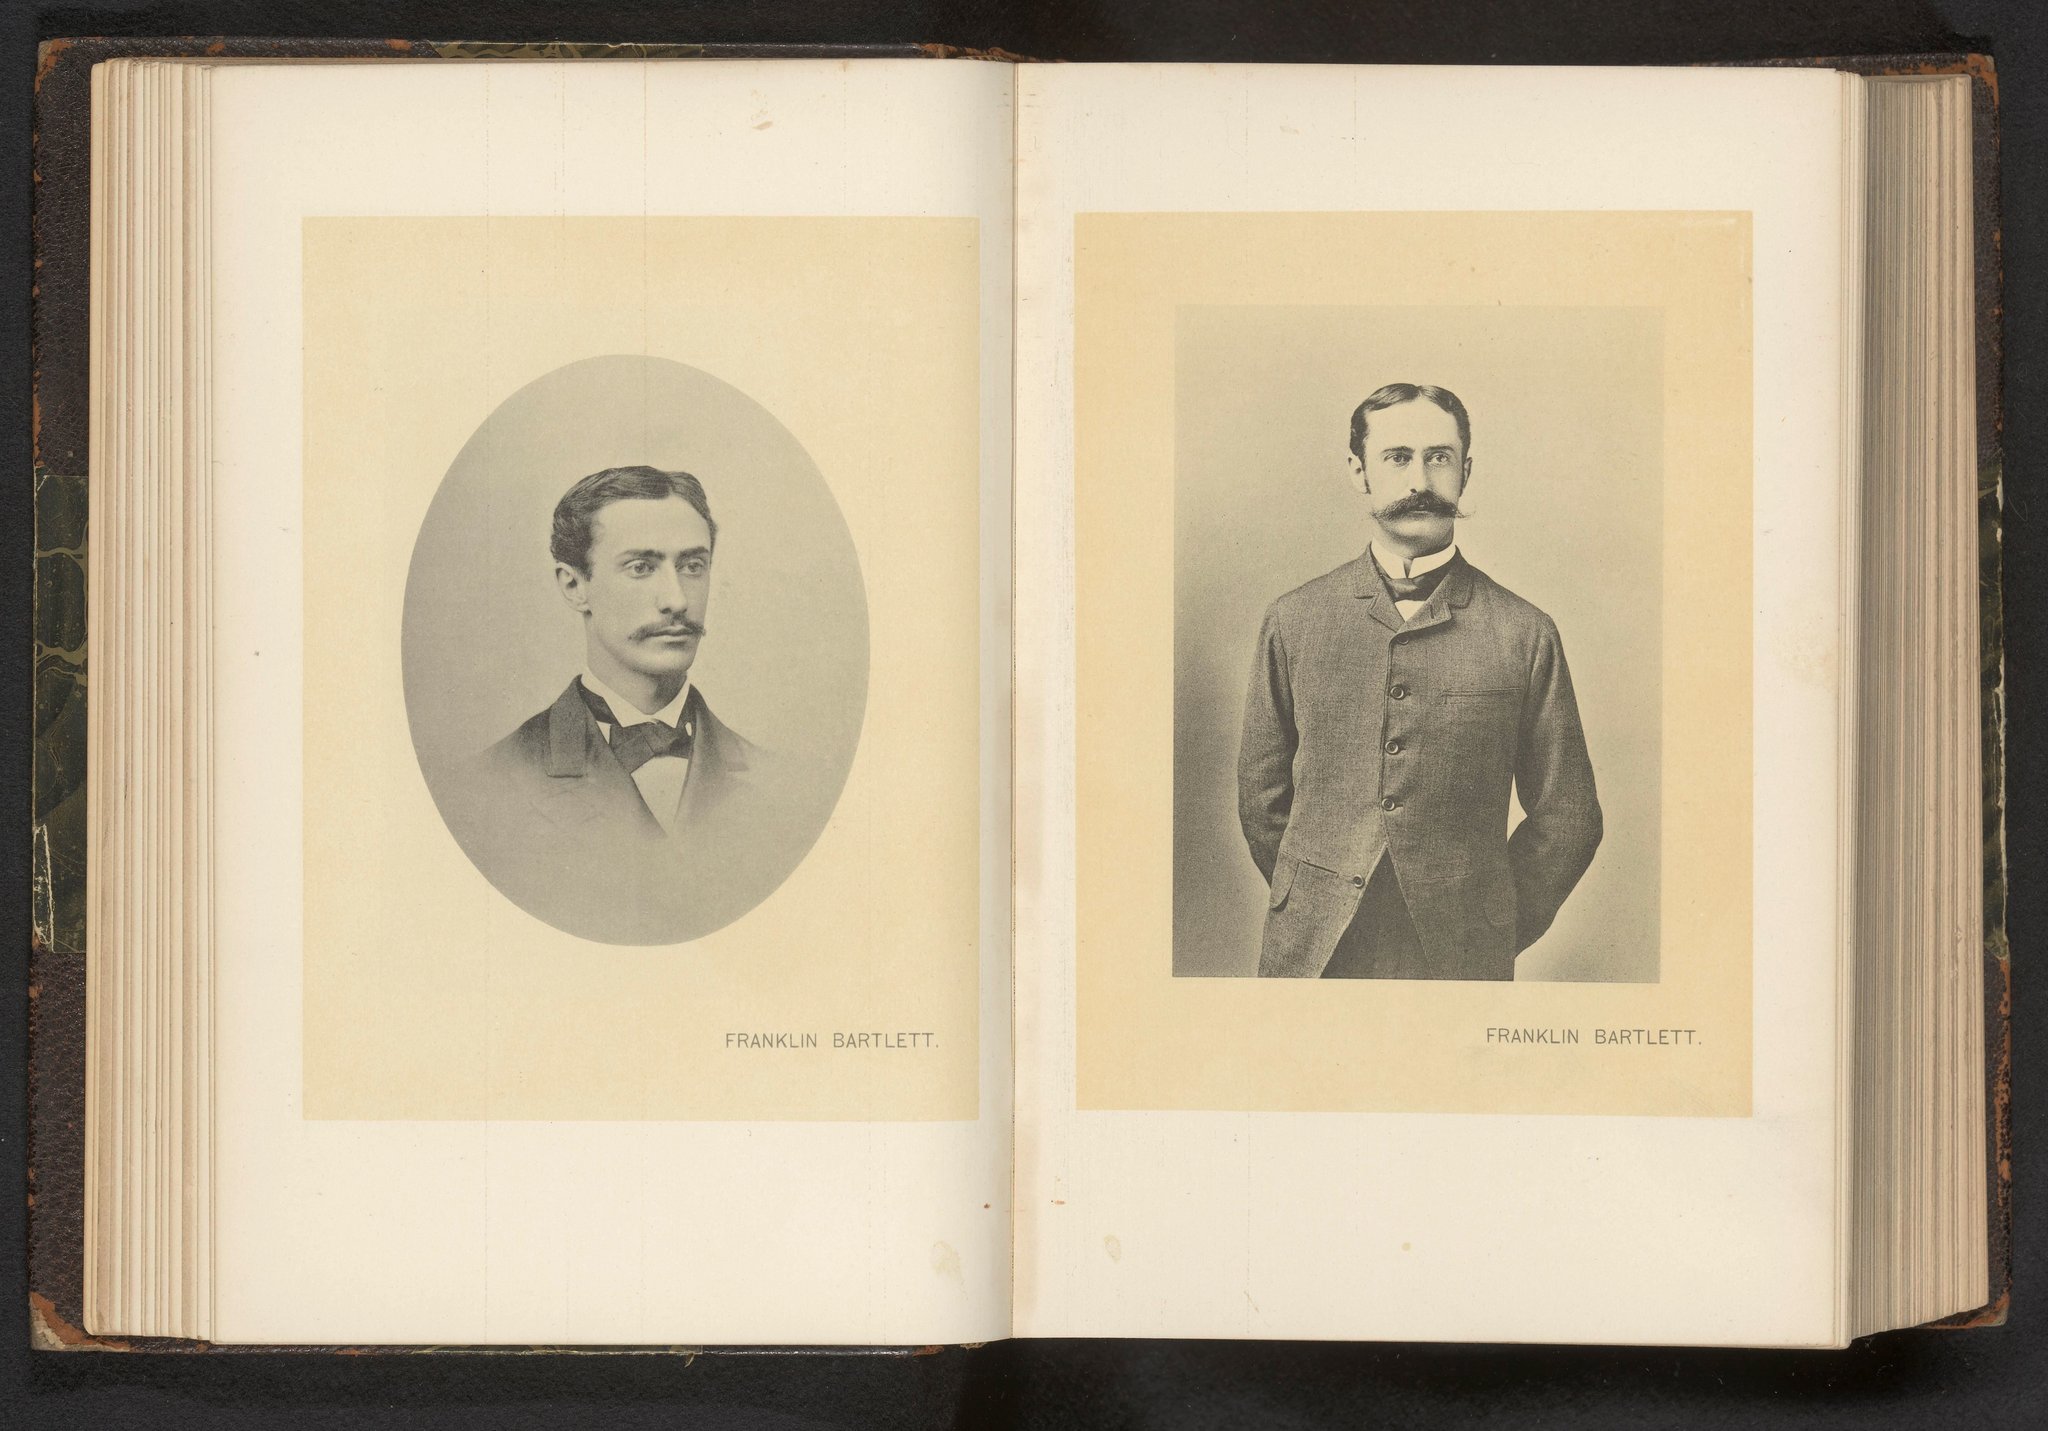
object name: photomechanical print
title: Franklin Bartlett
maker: Anonymous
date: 1869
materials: paper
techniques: photoaquatint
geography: boston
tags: politician, e.g. party leader